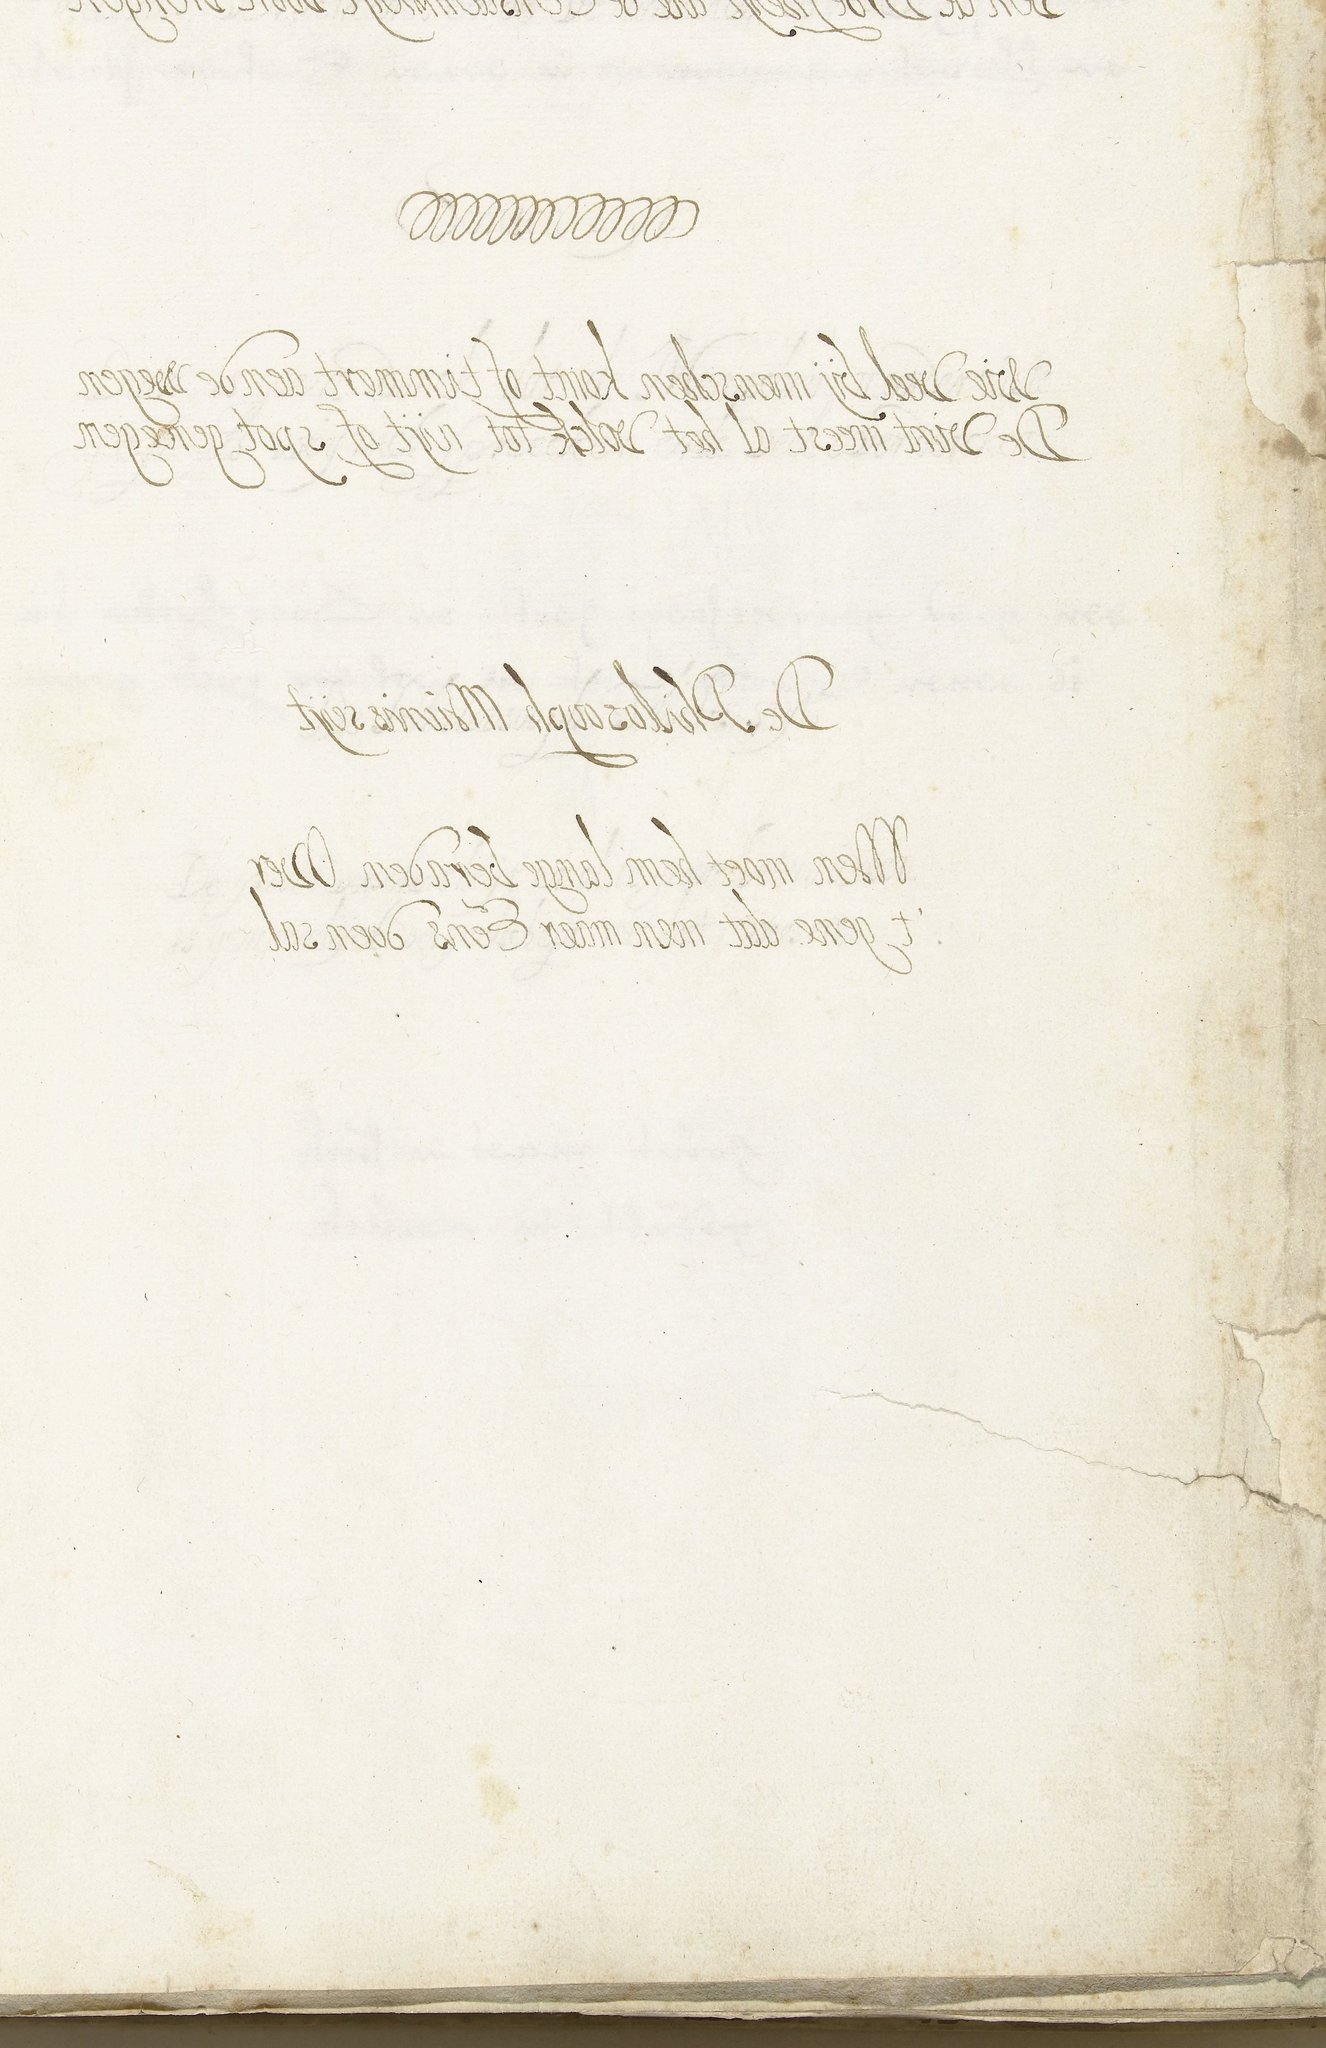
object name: calligraphy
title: Klassieke aforismen in spiegelbeeld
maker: gesina ter borch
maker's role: draughtsman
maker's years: 1633-1690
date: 1652-1680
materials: ink, paper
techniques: calligraphy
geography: zwolle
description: Het blad is later aan het Album toegevoegd en genummerd toen het opnieuw ingebonden werd.